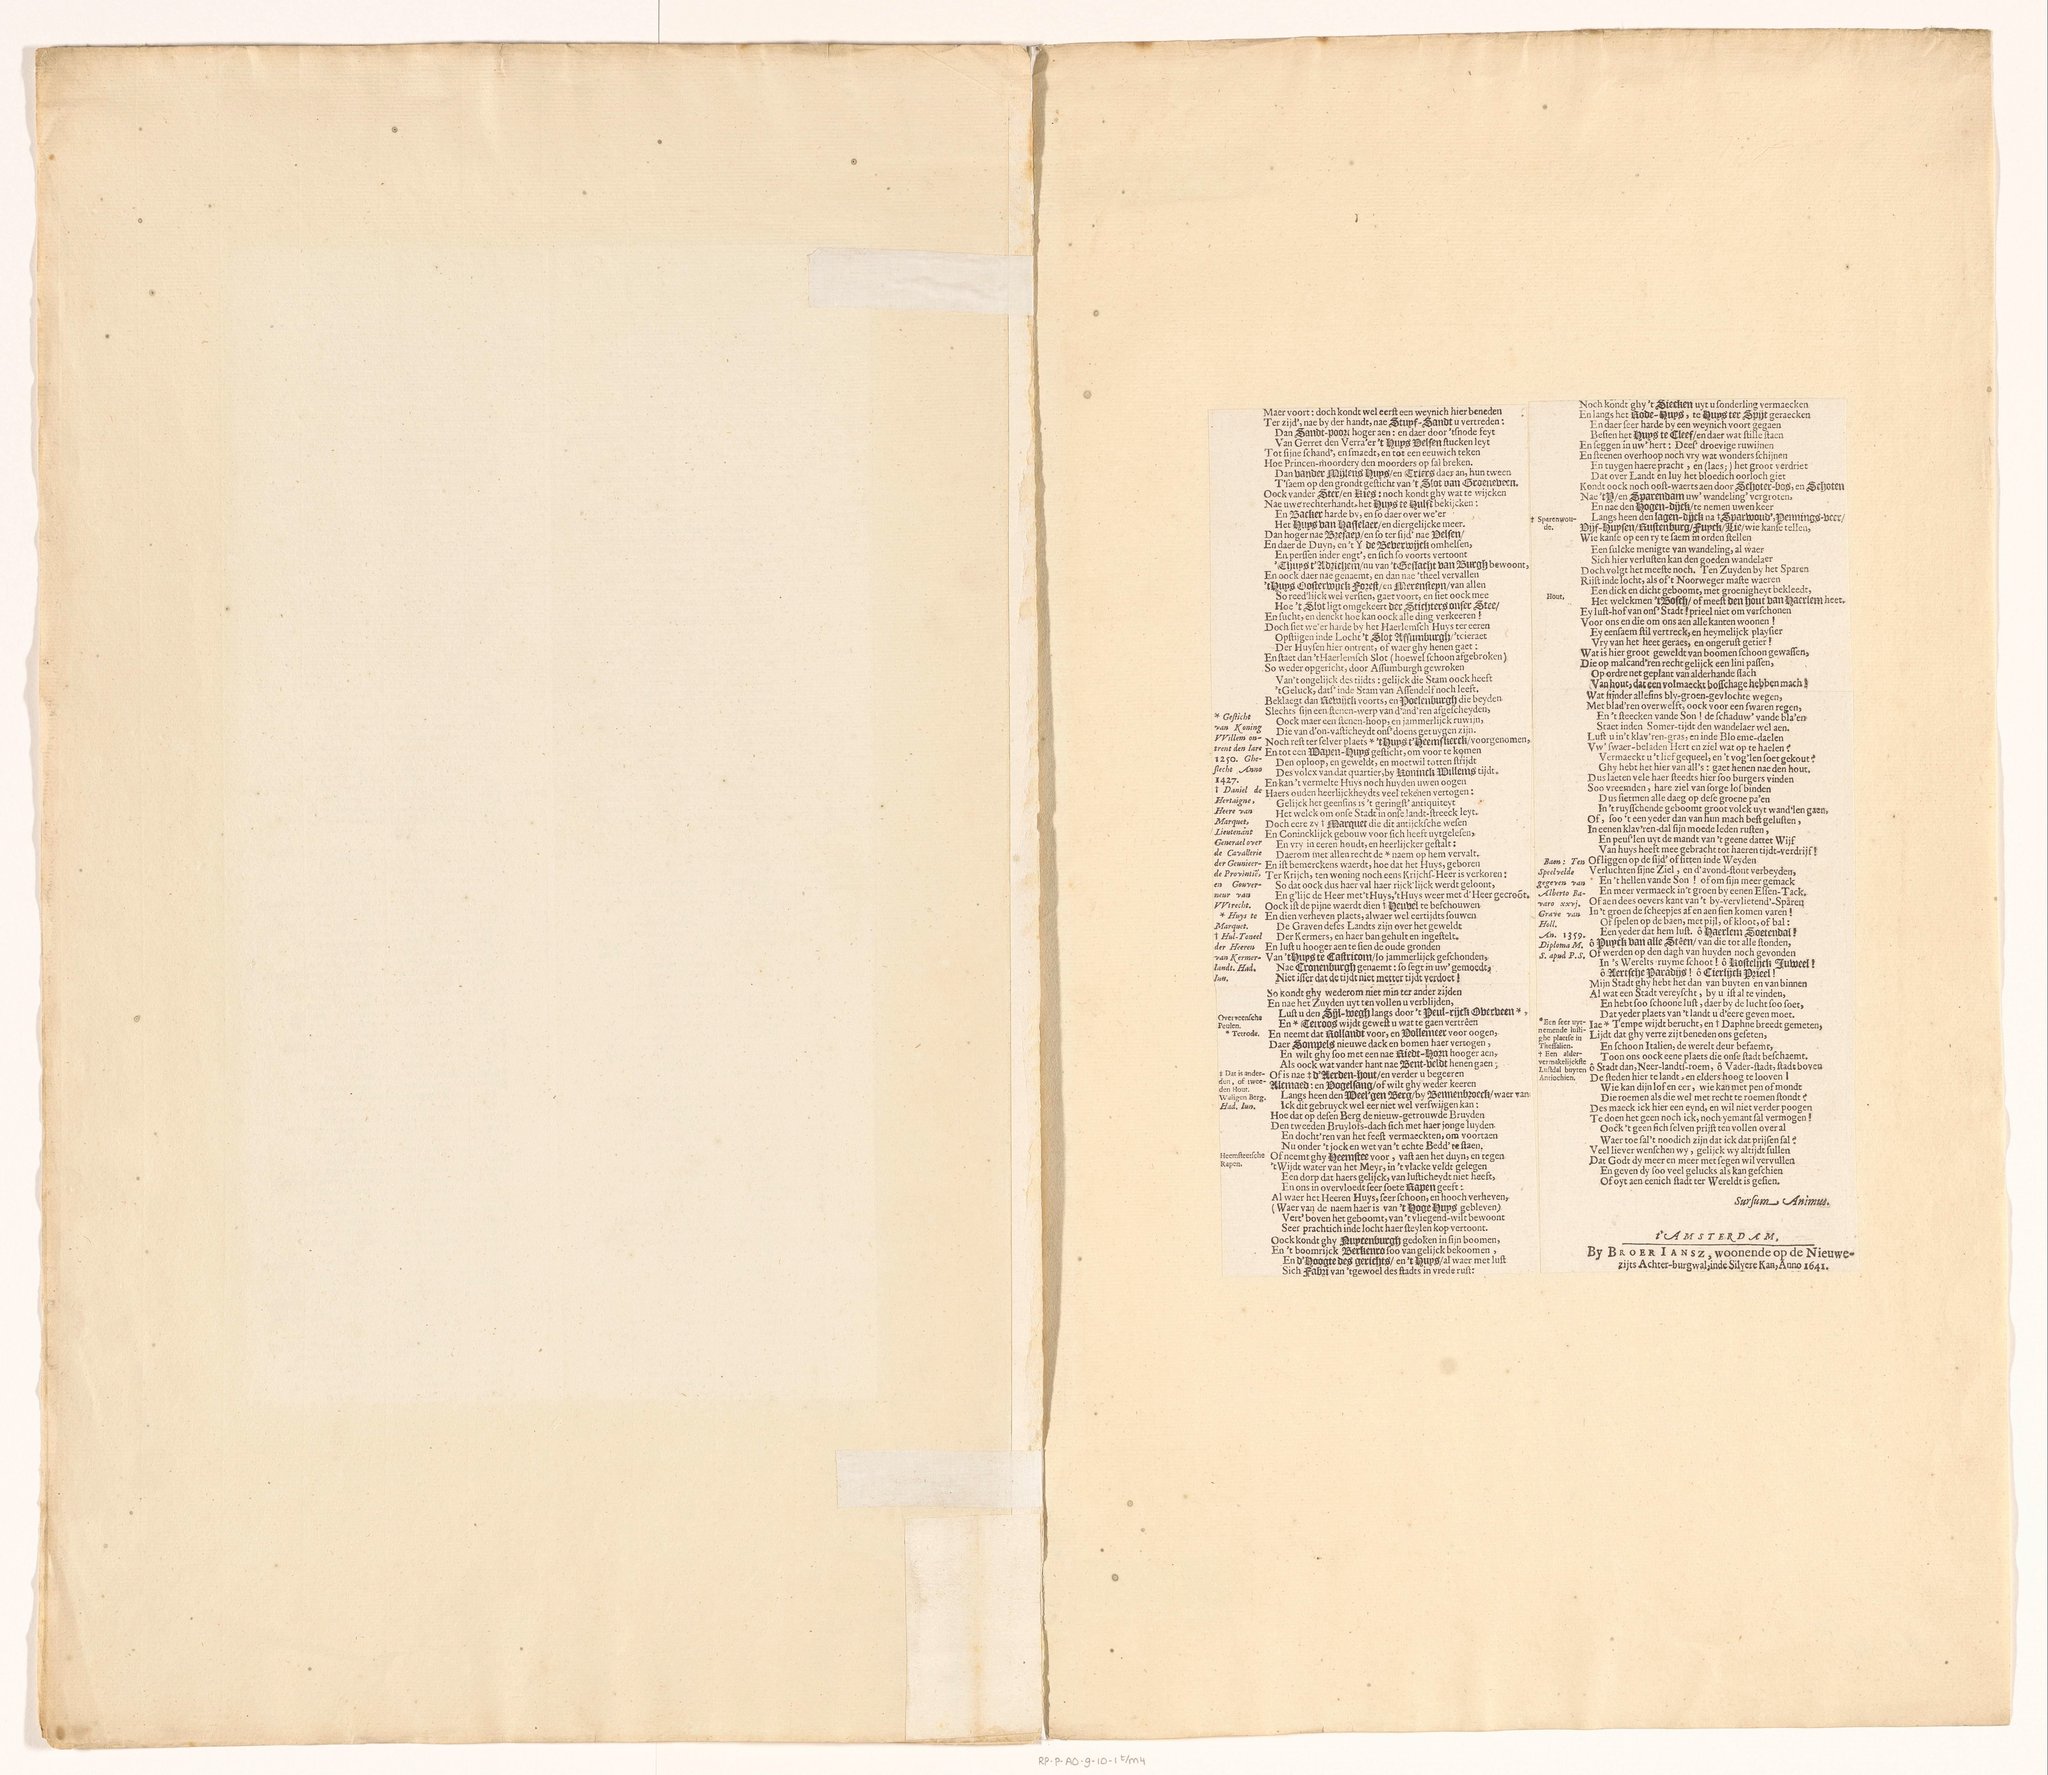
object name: text sheet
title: Deel van een beschrijving van de stad Haarlem in dichtvorm (4/4)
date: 1641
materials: paper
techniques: letterpress printing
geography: haarlem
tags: haarlem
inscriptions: date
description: Blad (vierde van vier) met een beschrijving van de stad Haarlem in dichtvorm.